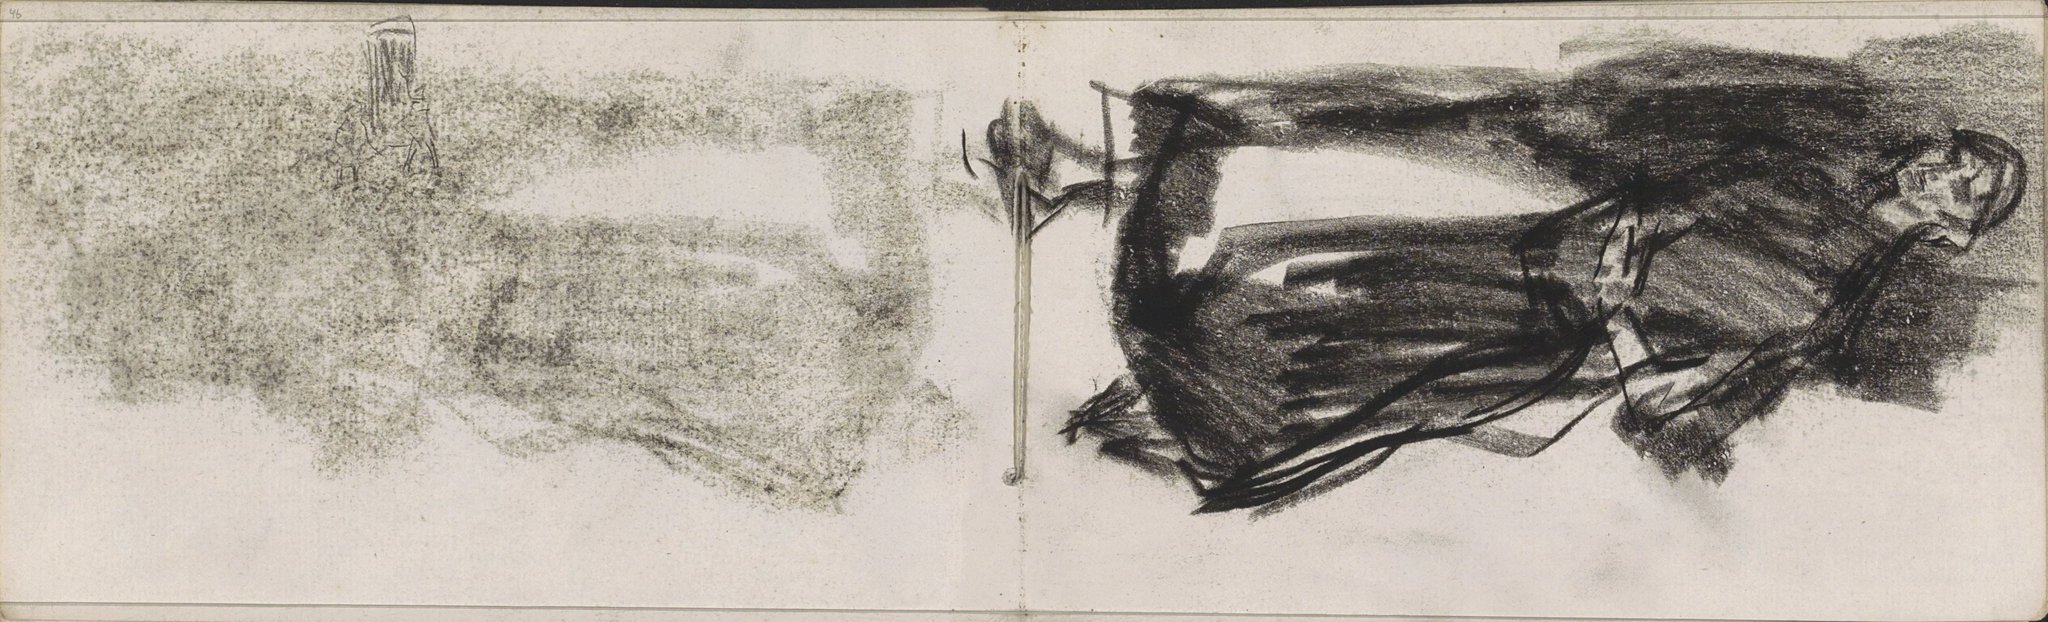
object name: sketchbook leaf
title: Lopende vrouw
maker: isaac israels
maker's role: draughtsman, painter, print maker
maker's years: 1865-1934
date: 1875-1934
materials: chalk, paper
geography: the hague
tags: walking - aa - female human figure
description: Pagina 46 en pagina 47 uit schetsboek XLVIII met 62 pagina's.